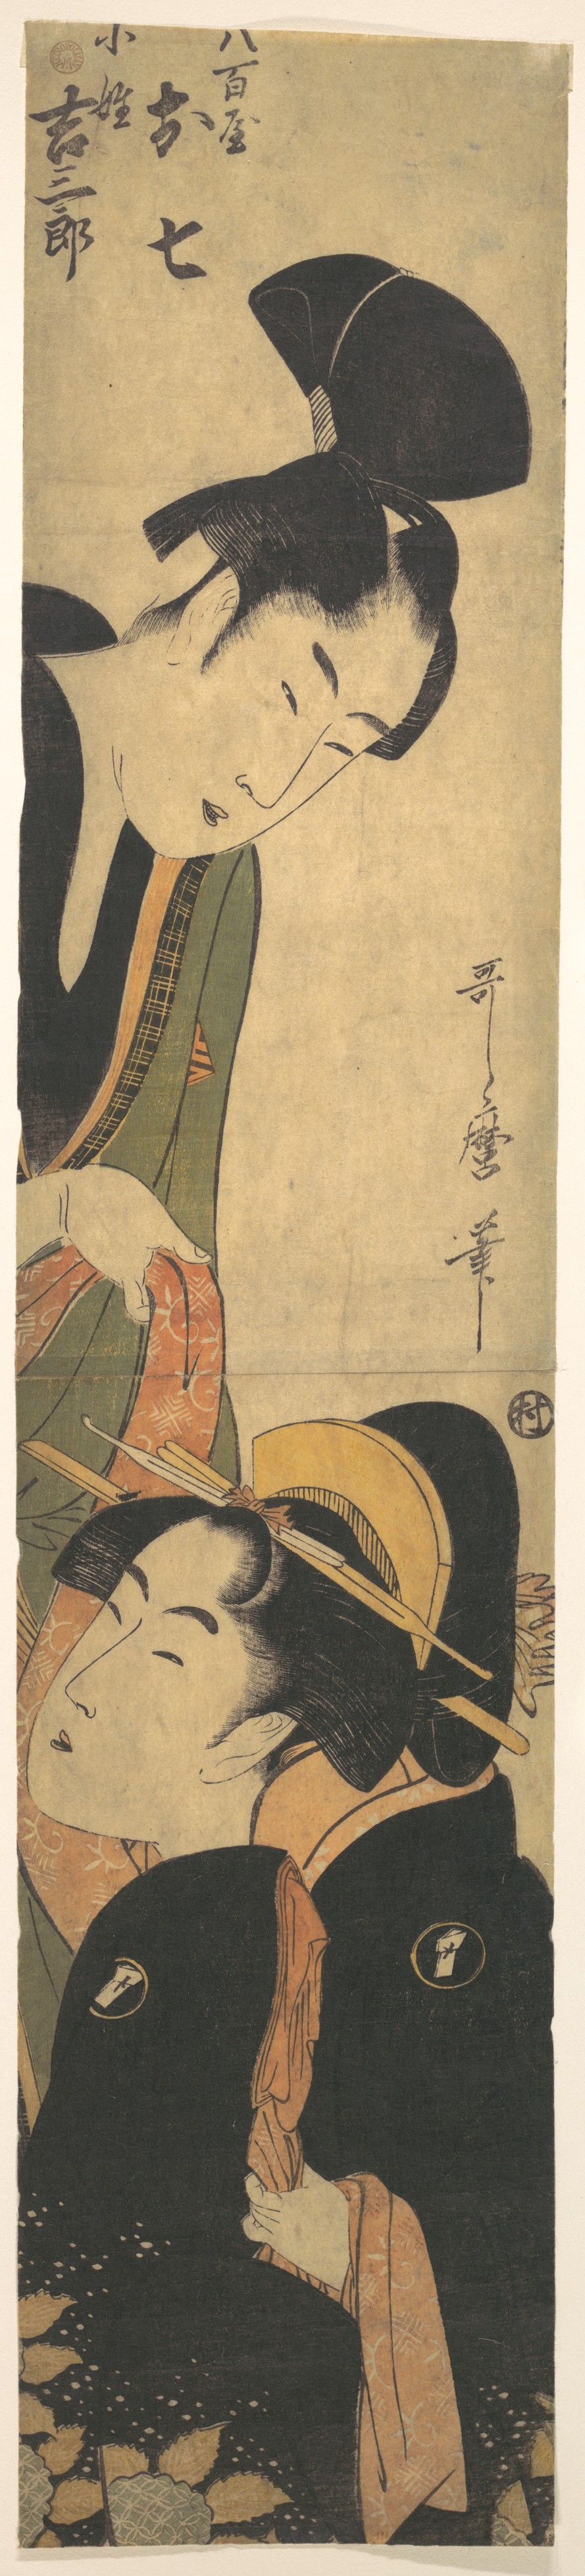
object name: print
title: O Shichi and Kichisaburo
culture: japanese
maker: kitagawa utamaro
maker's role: artist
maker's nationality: japanese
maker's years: 1754-1806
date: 1780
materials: ink, paper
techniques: woodblock print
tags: men,women